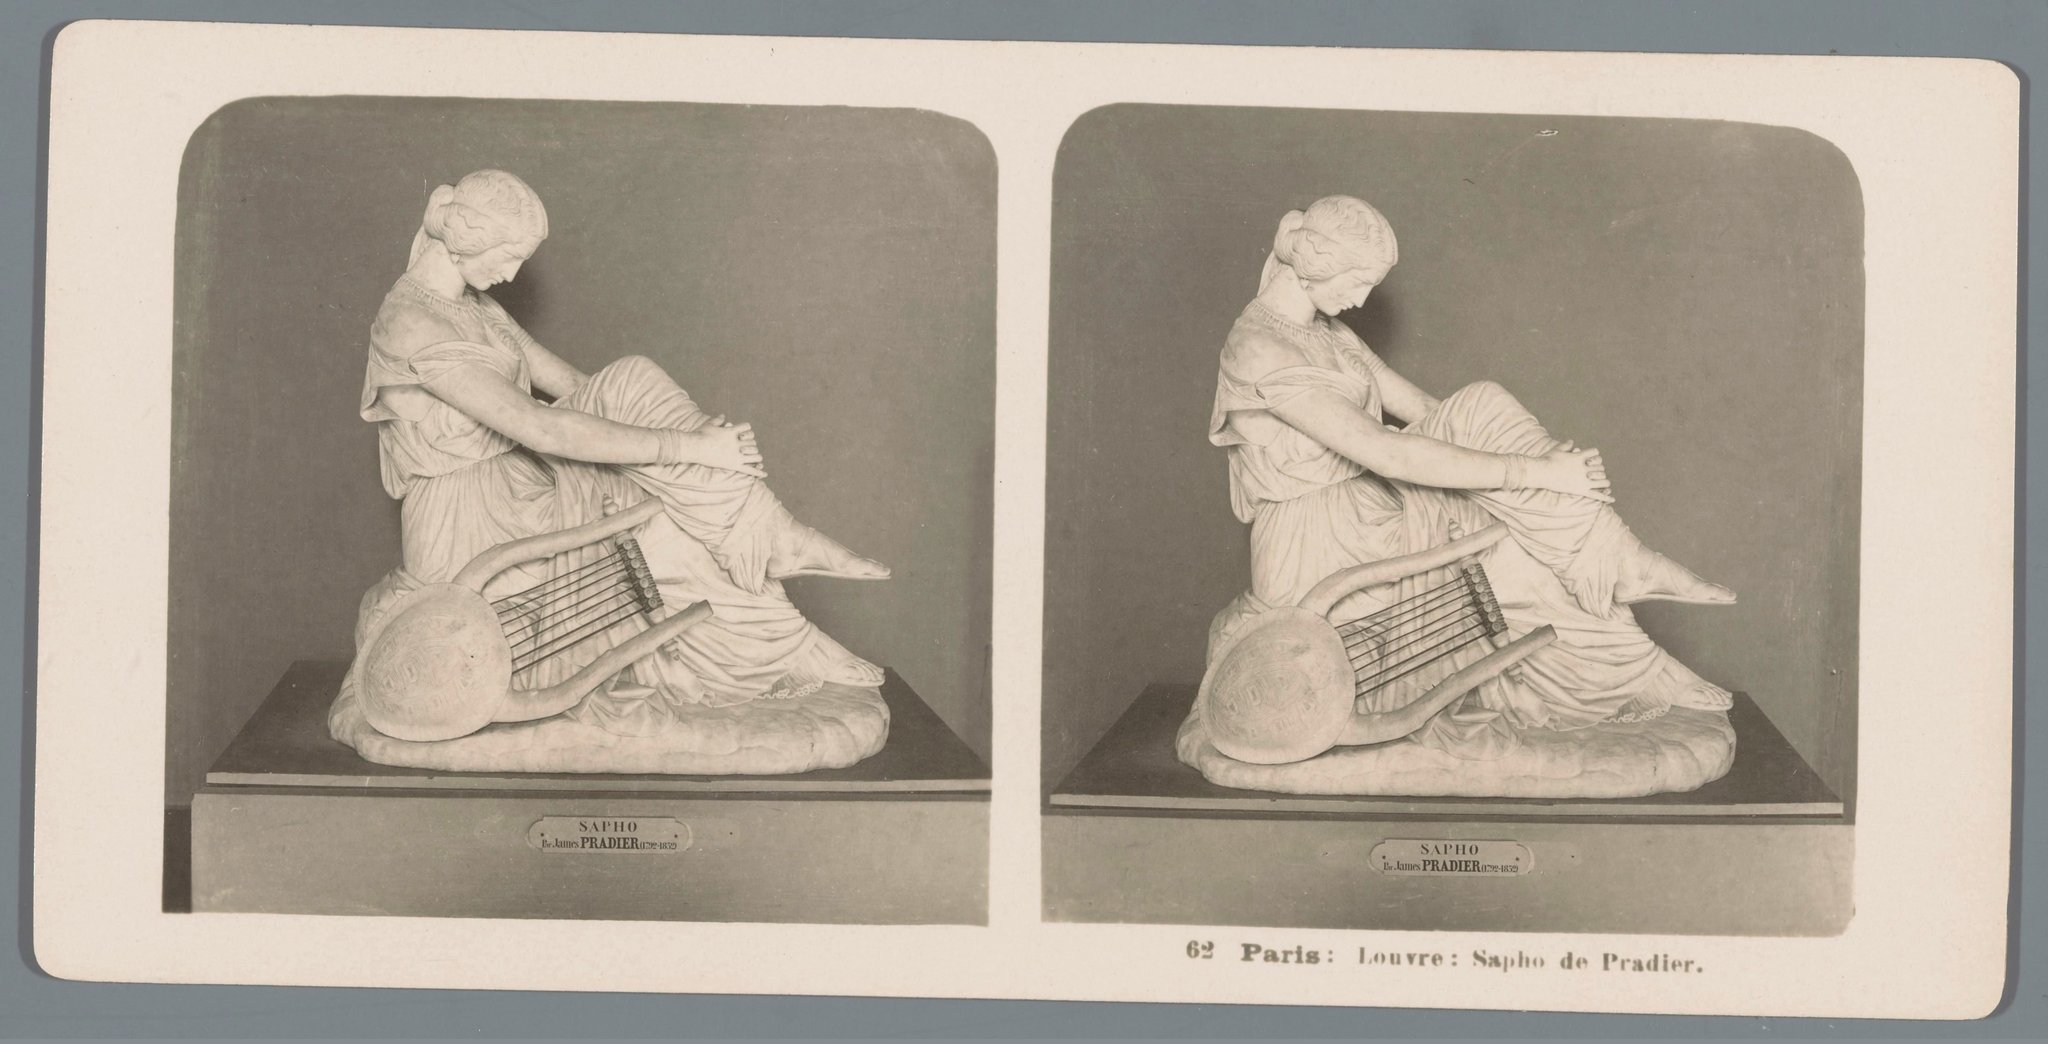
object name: stereograph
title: Sculptuur van James Pradier in het Musée du Louvre te Parijs, voorstellende Sappho met een kithara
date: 1903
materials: cardboard, photographic support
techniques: gelatin silver print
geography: louvre museum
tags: sitting figure - aa - female human figure, (story of) sappho, the poetess, lyre, cithara, psaltery, sculpture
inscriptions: inscription: ‘Neue Photographische Gesellschaft A.-G. Steglitz-Berlin 1903.’, number: ‘62’